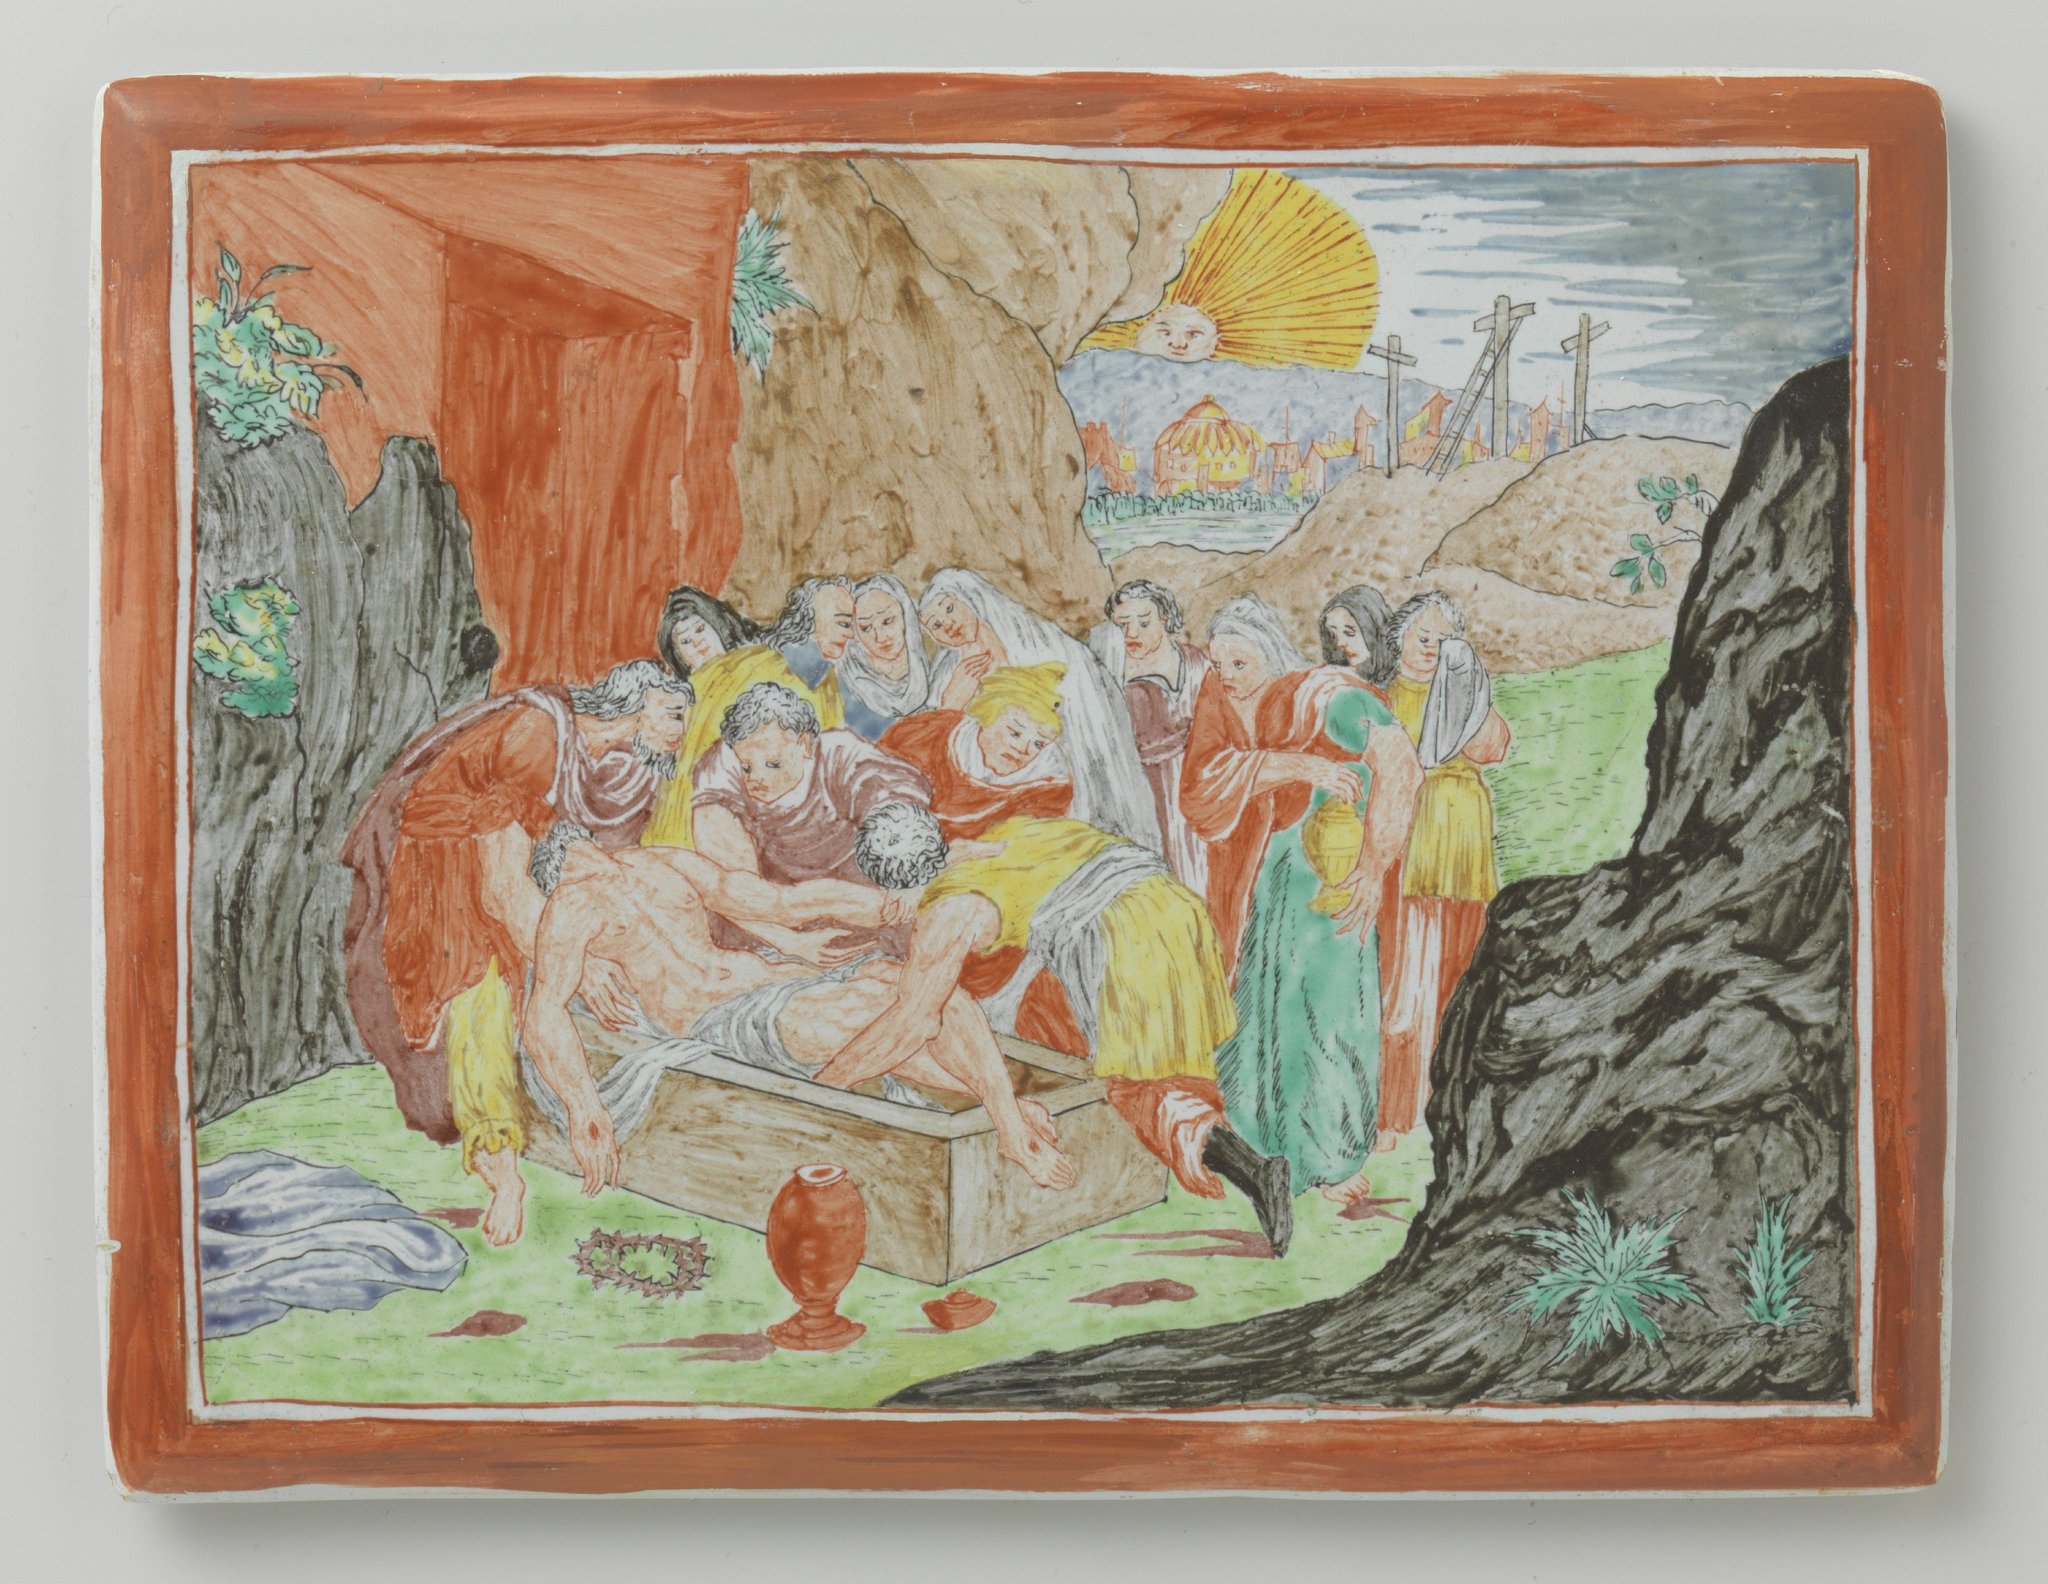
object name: plate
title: Rechthoekige plaat met de graflegging van Christus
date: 1730-1760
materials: faience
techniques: kiln, painted, polychromy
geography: delft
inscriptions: collector's mark: ‘collection JF Loudon’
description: Rechthoekige plaat veelkleurig beschilderd met de graflegging van Christus ontleend aan een prent van Johannes Sadeler naar een tekening van Dirck Barendsz.